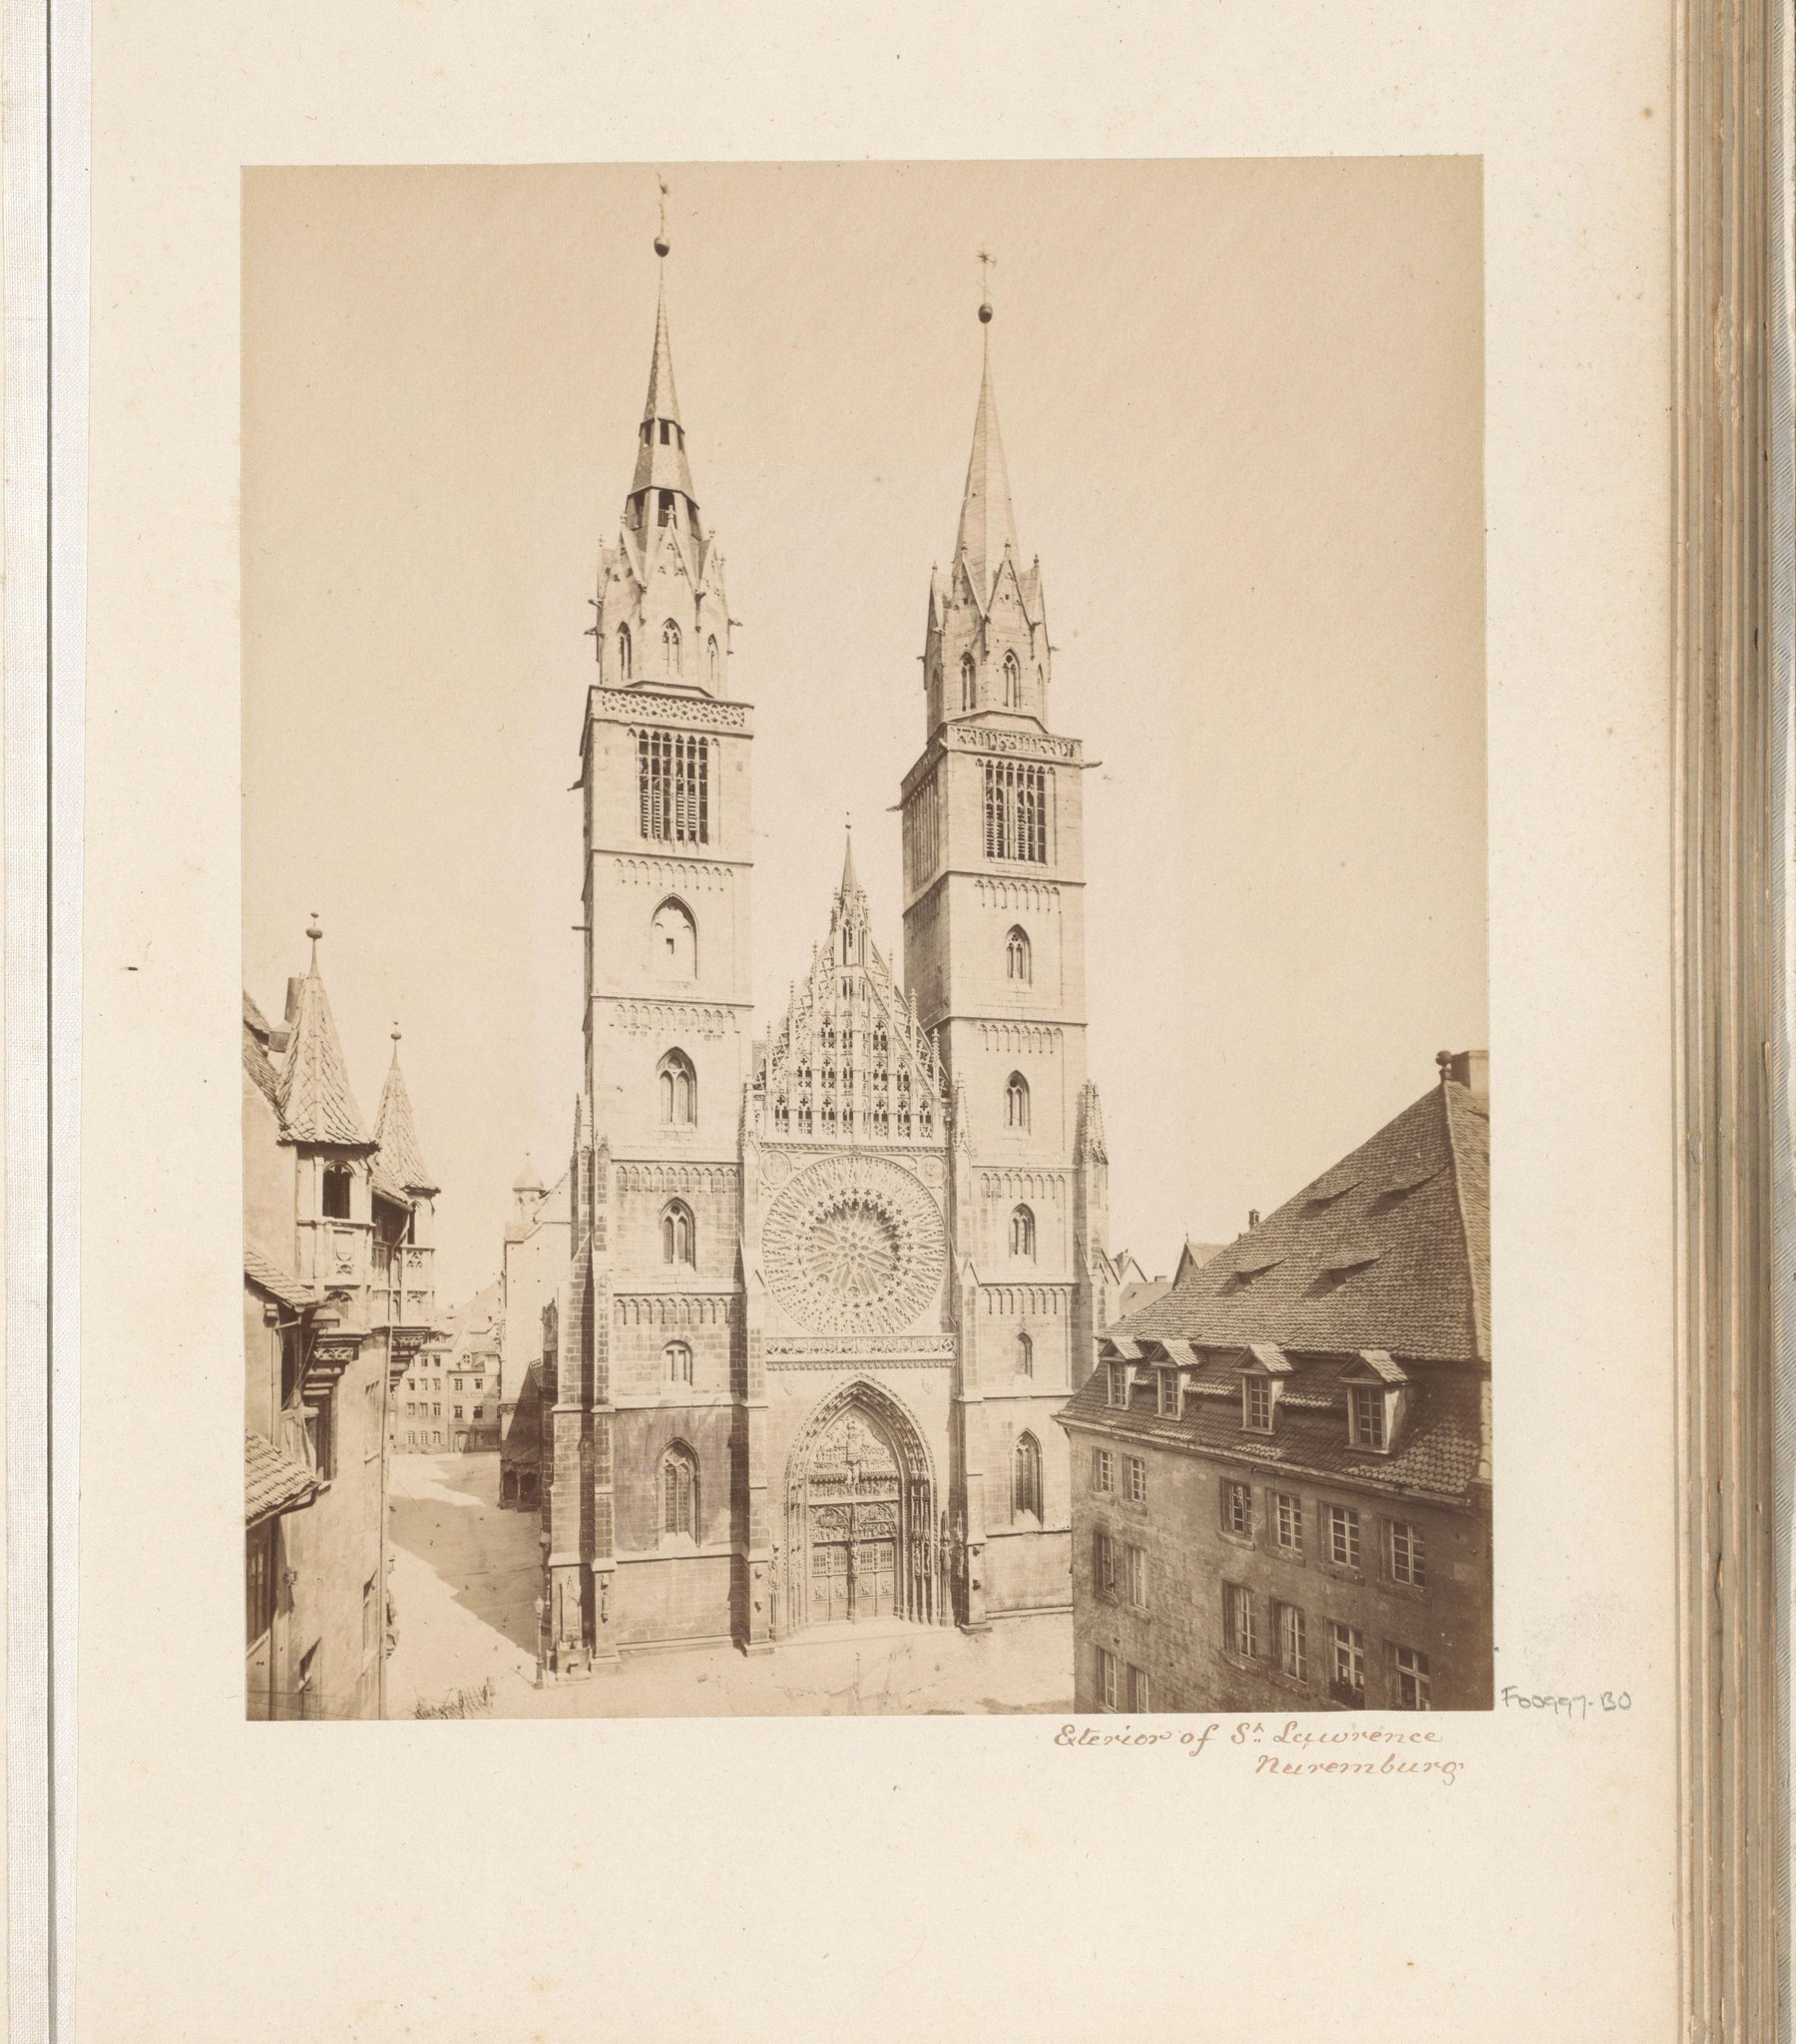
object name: photograph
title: Exterior of St. Lawrence Nuremburg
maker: Anonymous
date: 1860-1890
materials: paper, photographic support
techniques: albumen print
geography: nuremberg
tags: church (exterior)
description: Onderdeel van Reisalbum met foto's van Zwitserland, Oostenrijk, Italië en Duitsland.